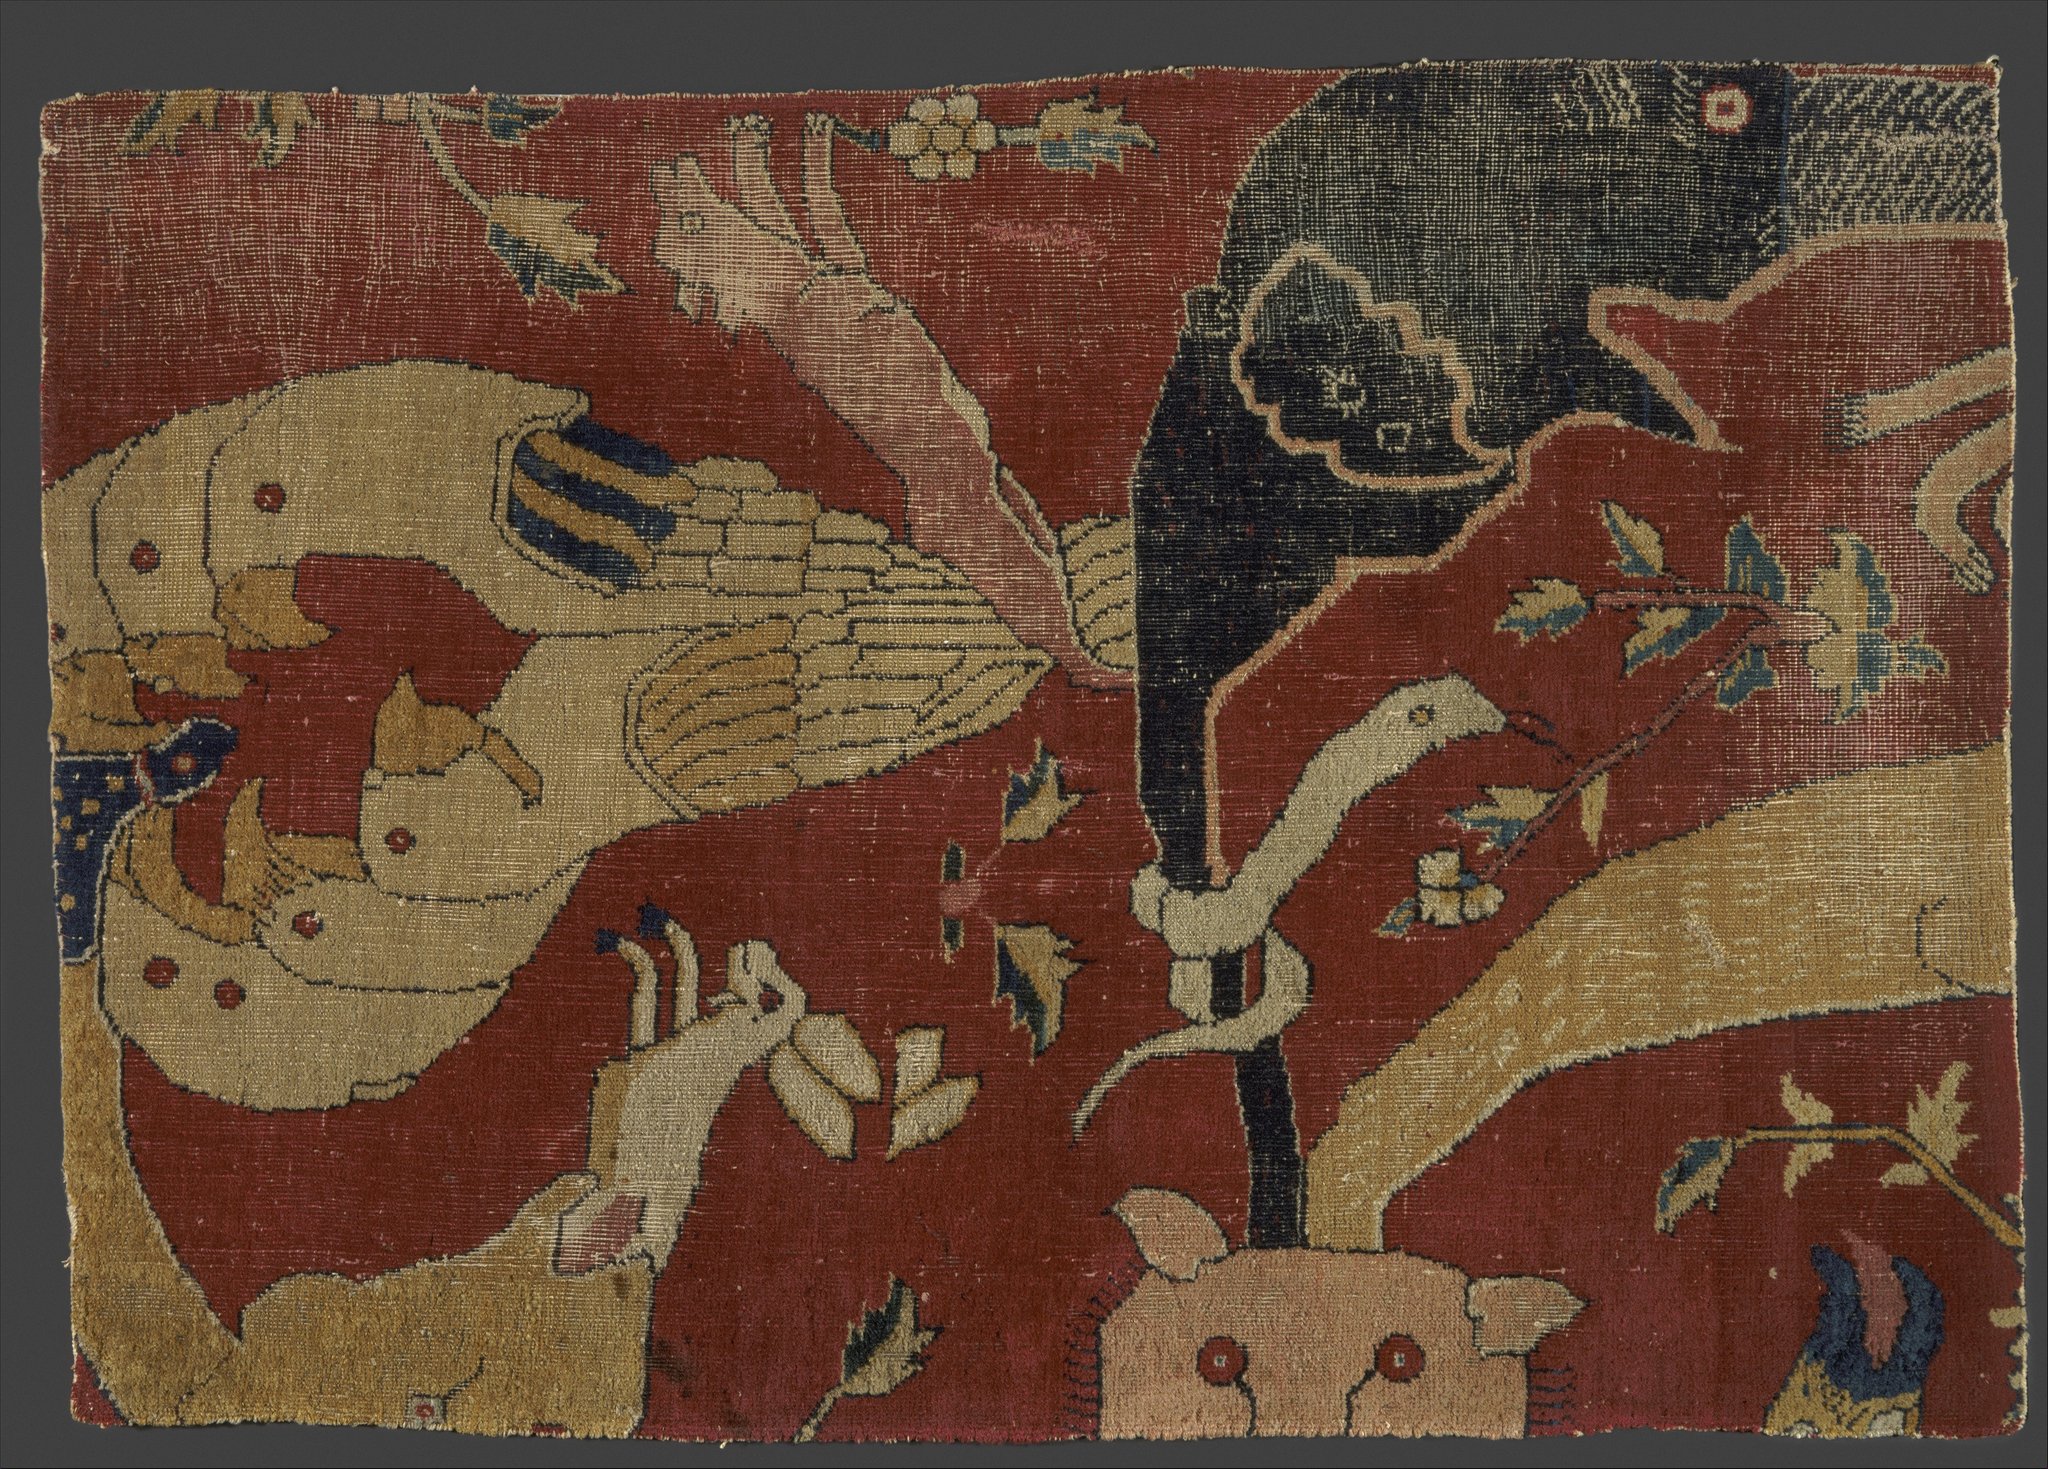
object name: carpet fragment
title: Fragment of an Animal Carpet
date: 1567-1600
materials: cotton, wool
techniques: asymmetrically knotted pile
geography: northern india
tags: animals